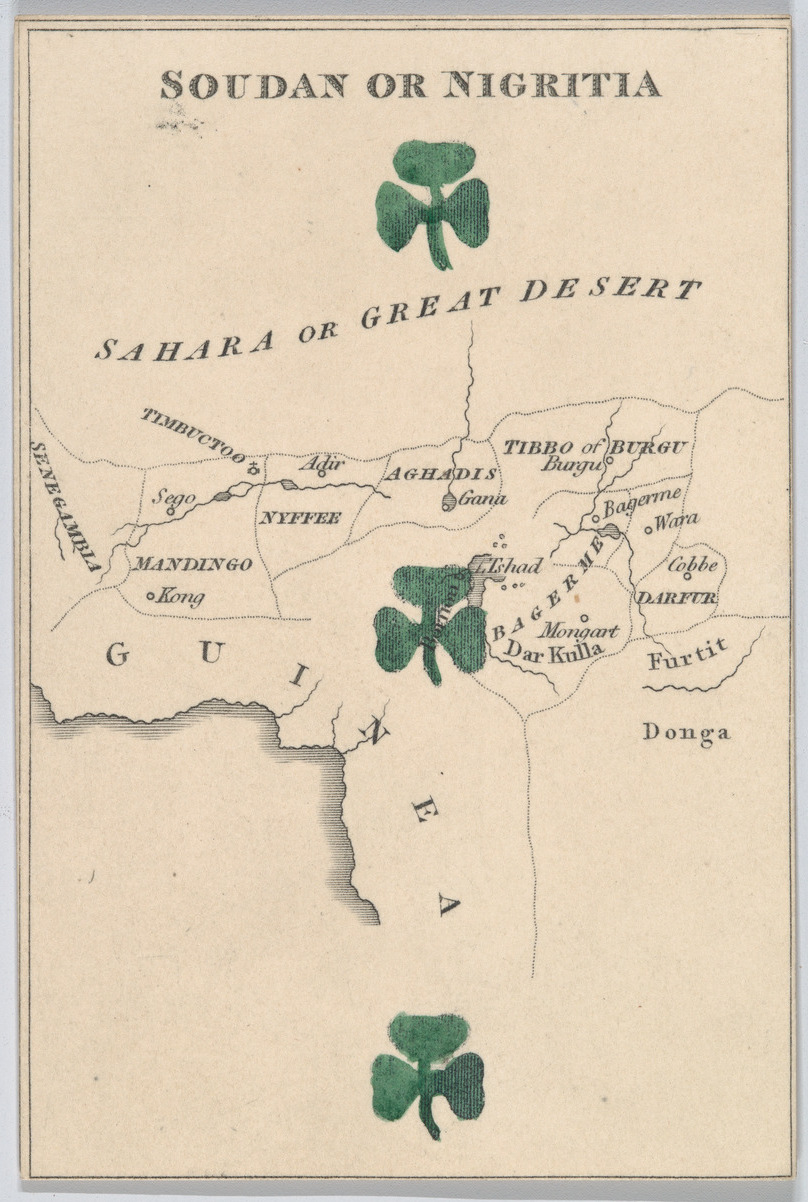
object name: print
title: Soudan or Nigritia, from "Court Game of Geography"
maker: william and henry rock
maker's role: publisher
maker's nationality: british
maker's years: 1821-1884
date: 1838-1855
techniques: engraving, hand coloring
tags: playing cards,maps